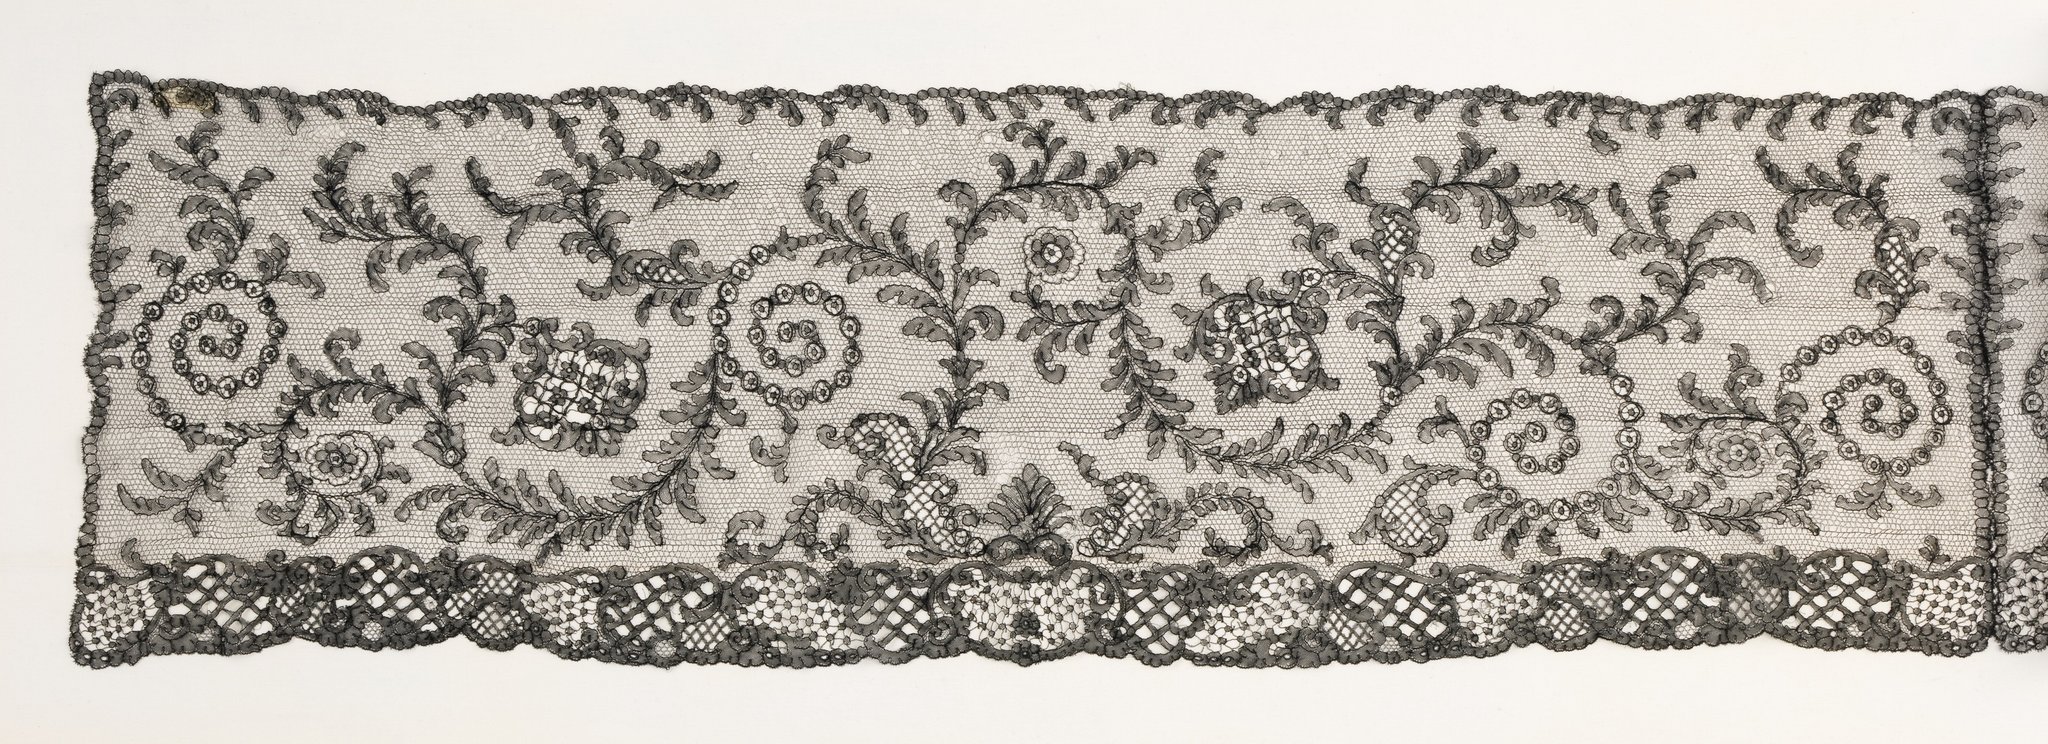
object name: evening shawl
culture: european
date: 1850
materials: silk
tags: flowers